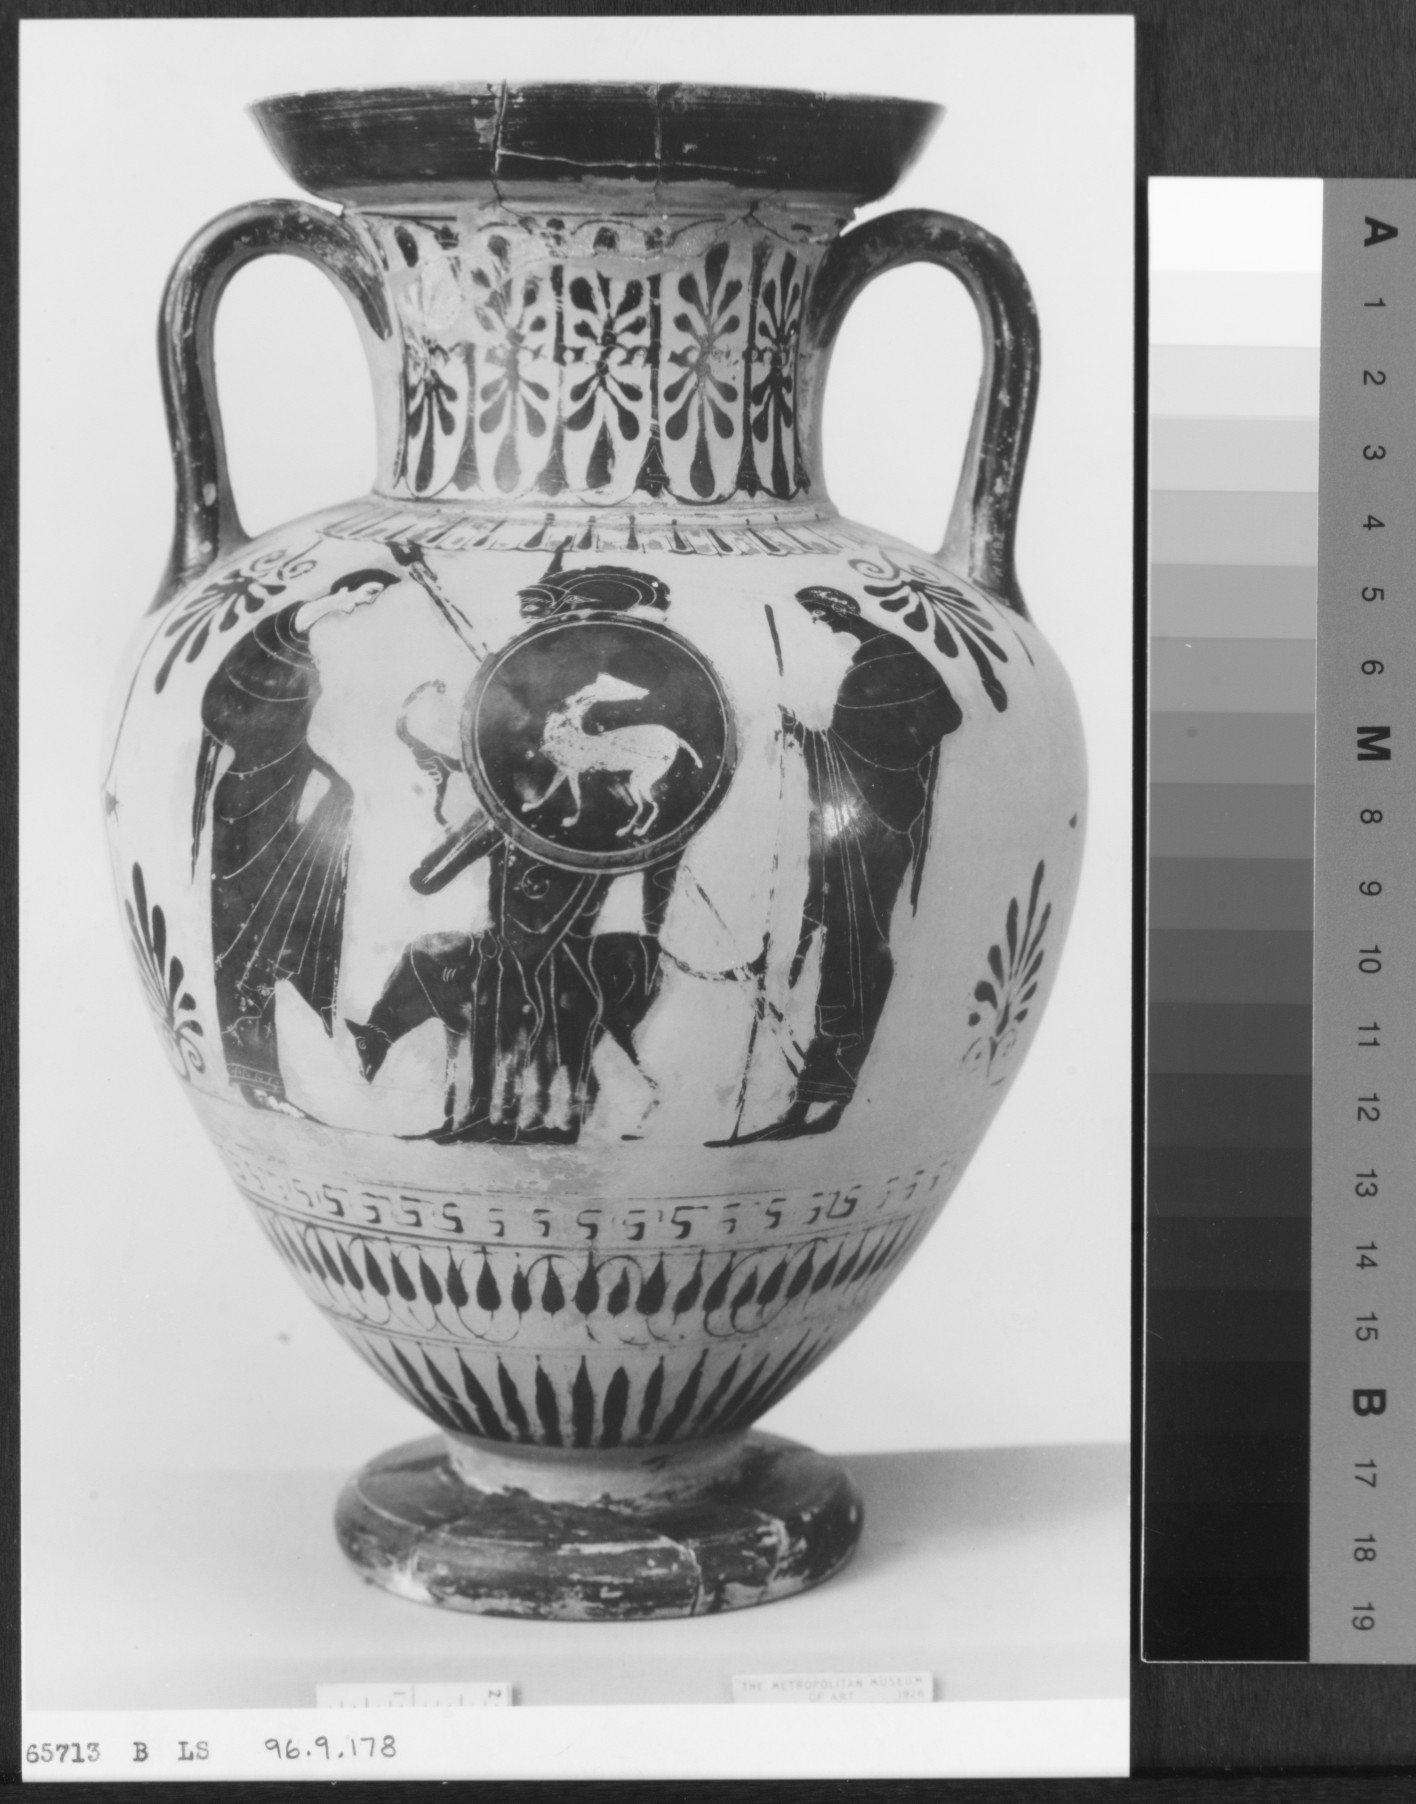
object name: neck amphora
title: Neck-amphora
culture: greek, attic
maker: painter of oxford 213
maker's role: artist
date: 525-501 BCE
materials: terracotta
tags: animals,shields,men,dogs